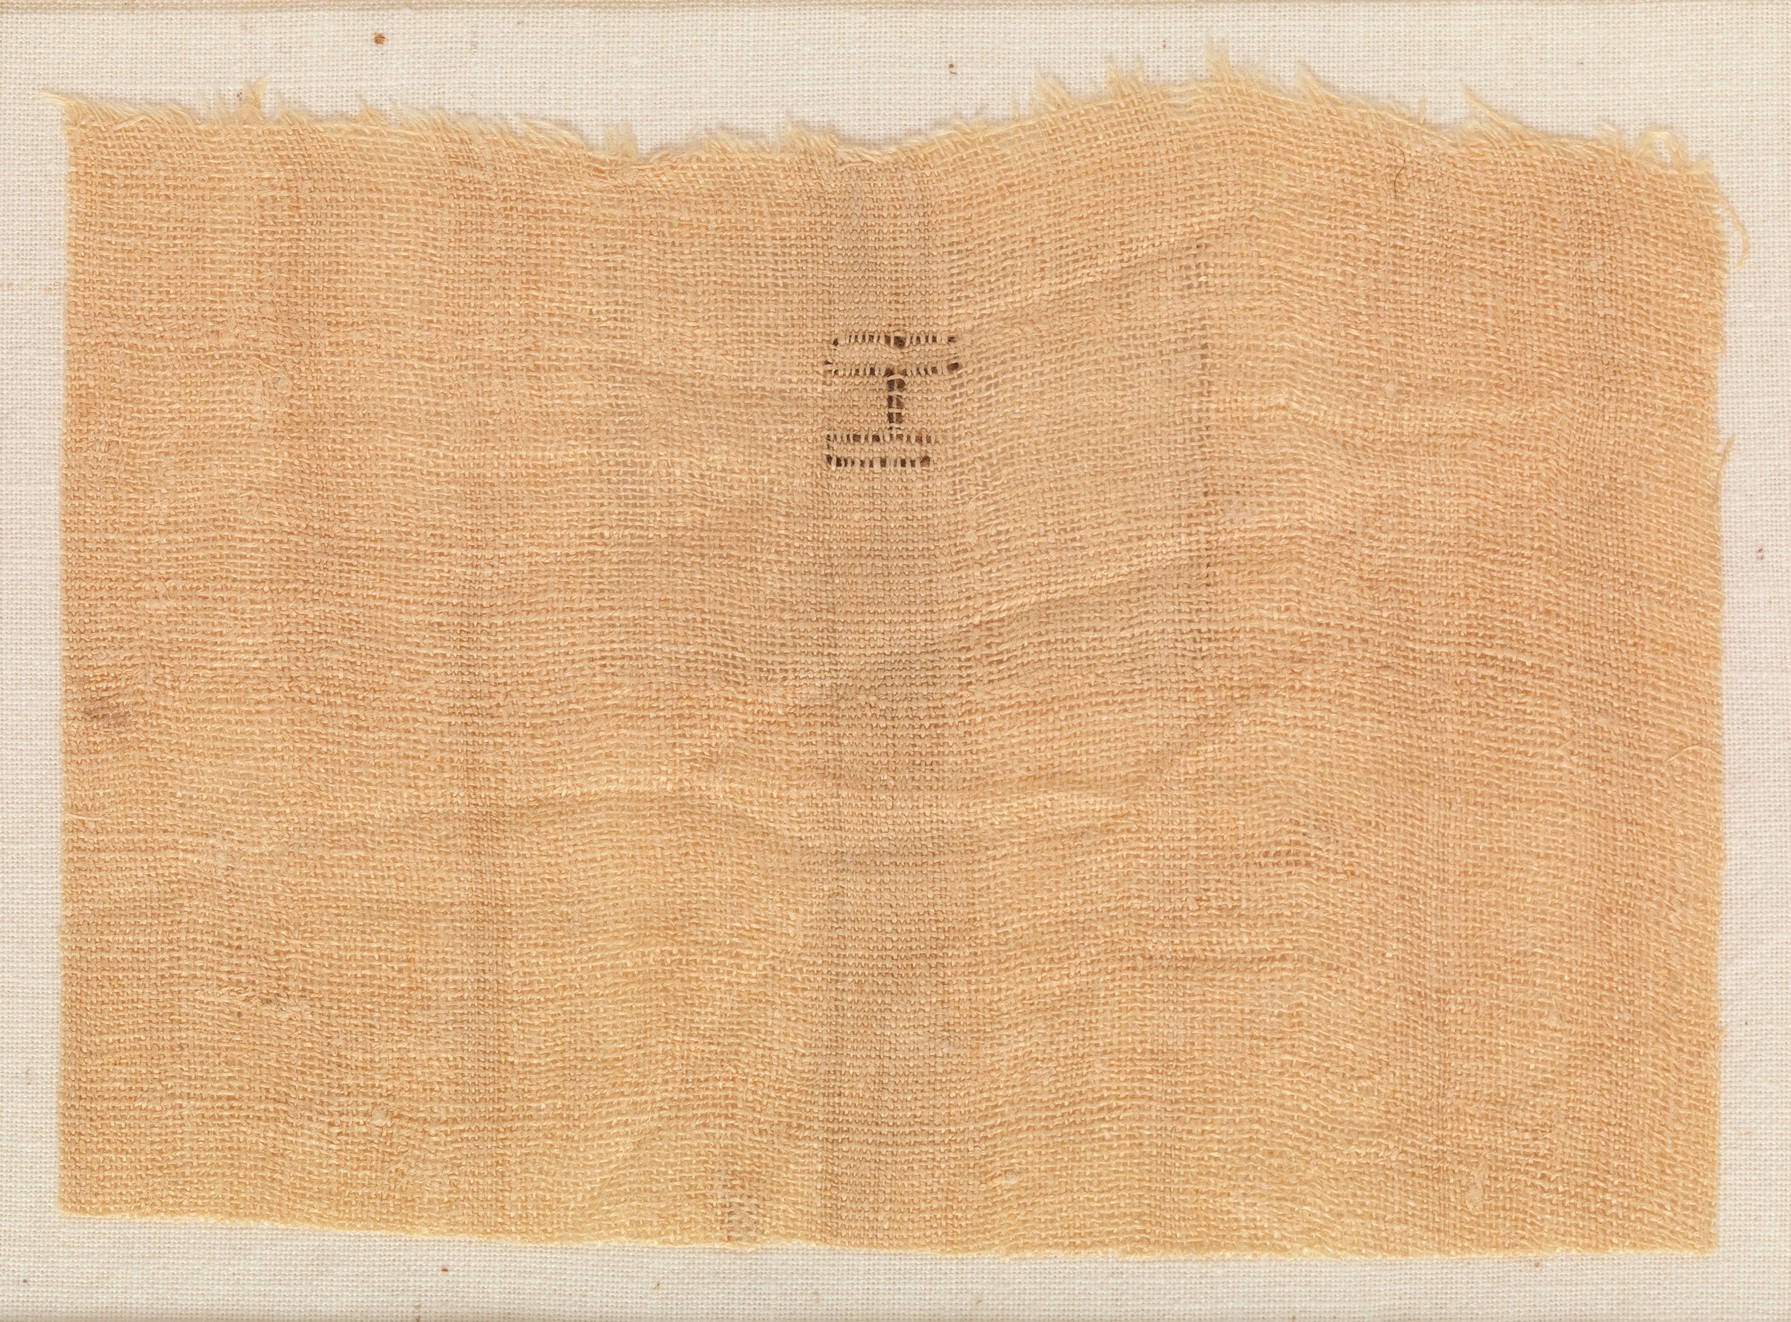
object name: linen mark, wah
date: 1981-1975 BCE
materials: linen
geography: egypt